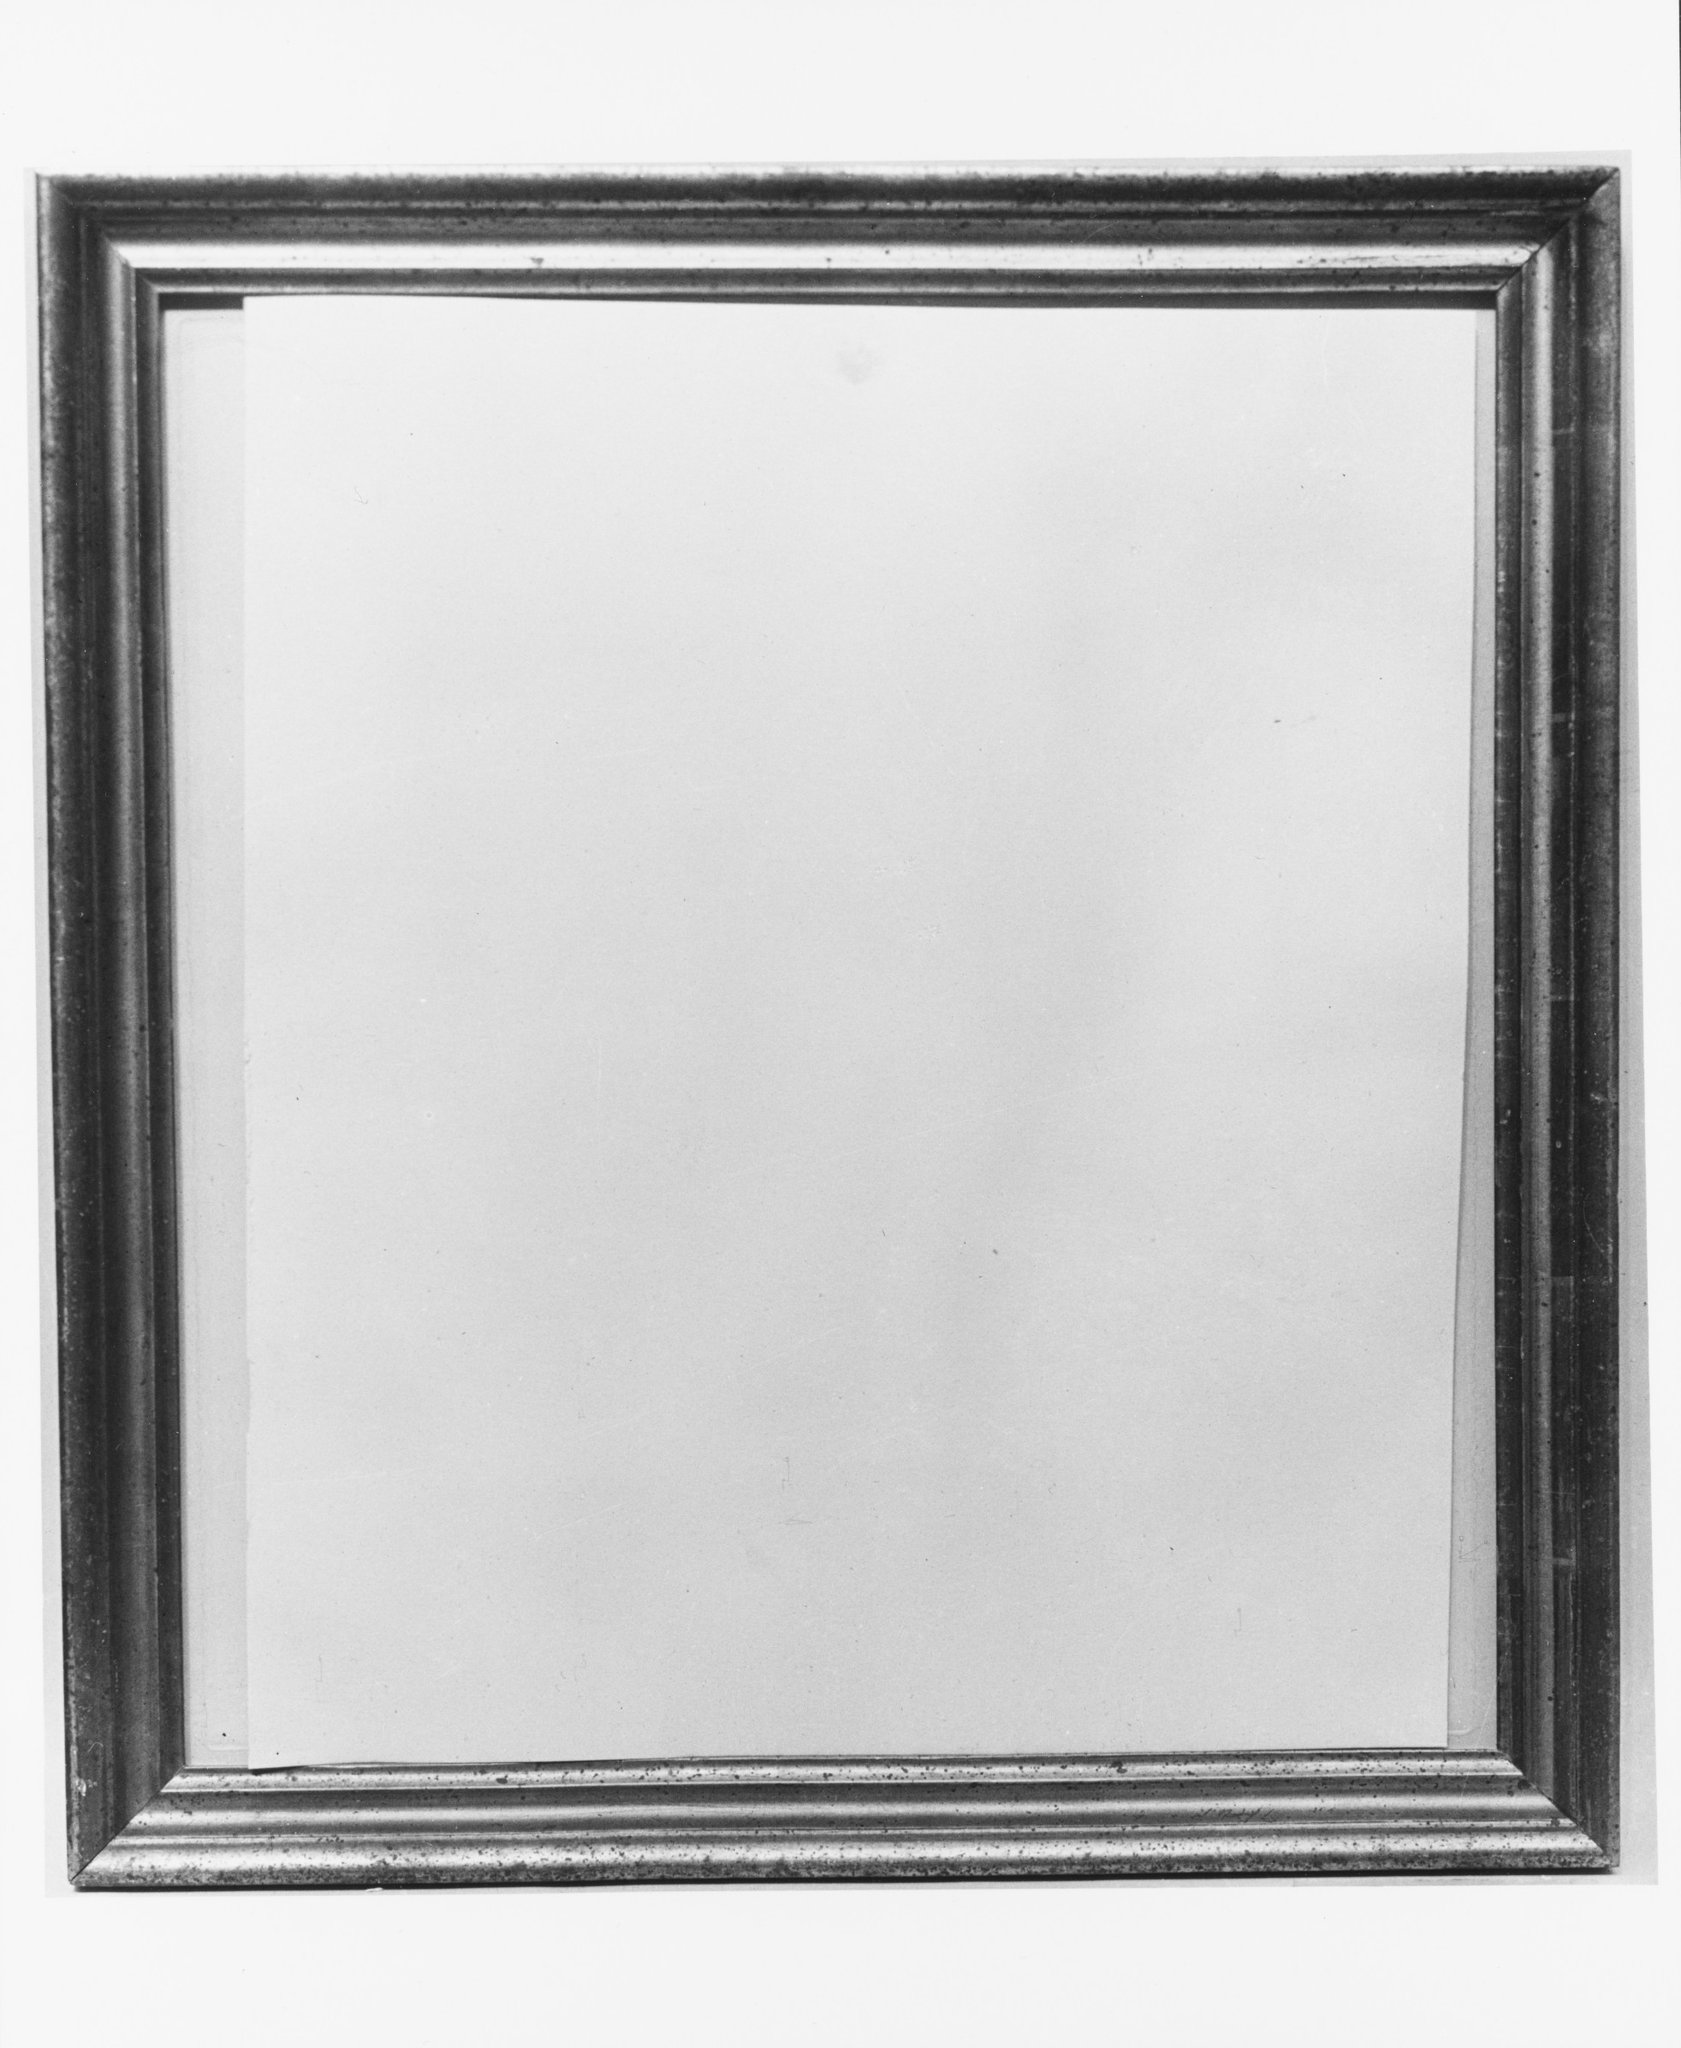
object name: frame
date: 1830-1870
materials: gilt, wood